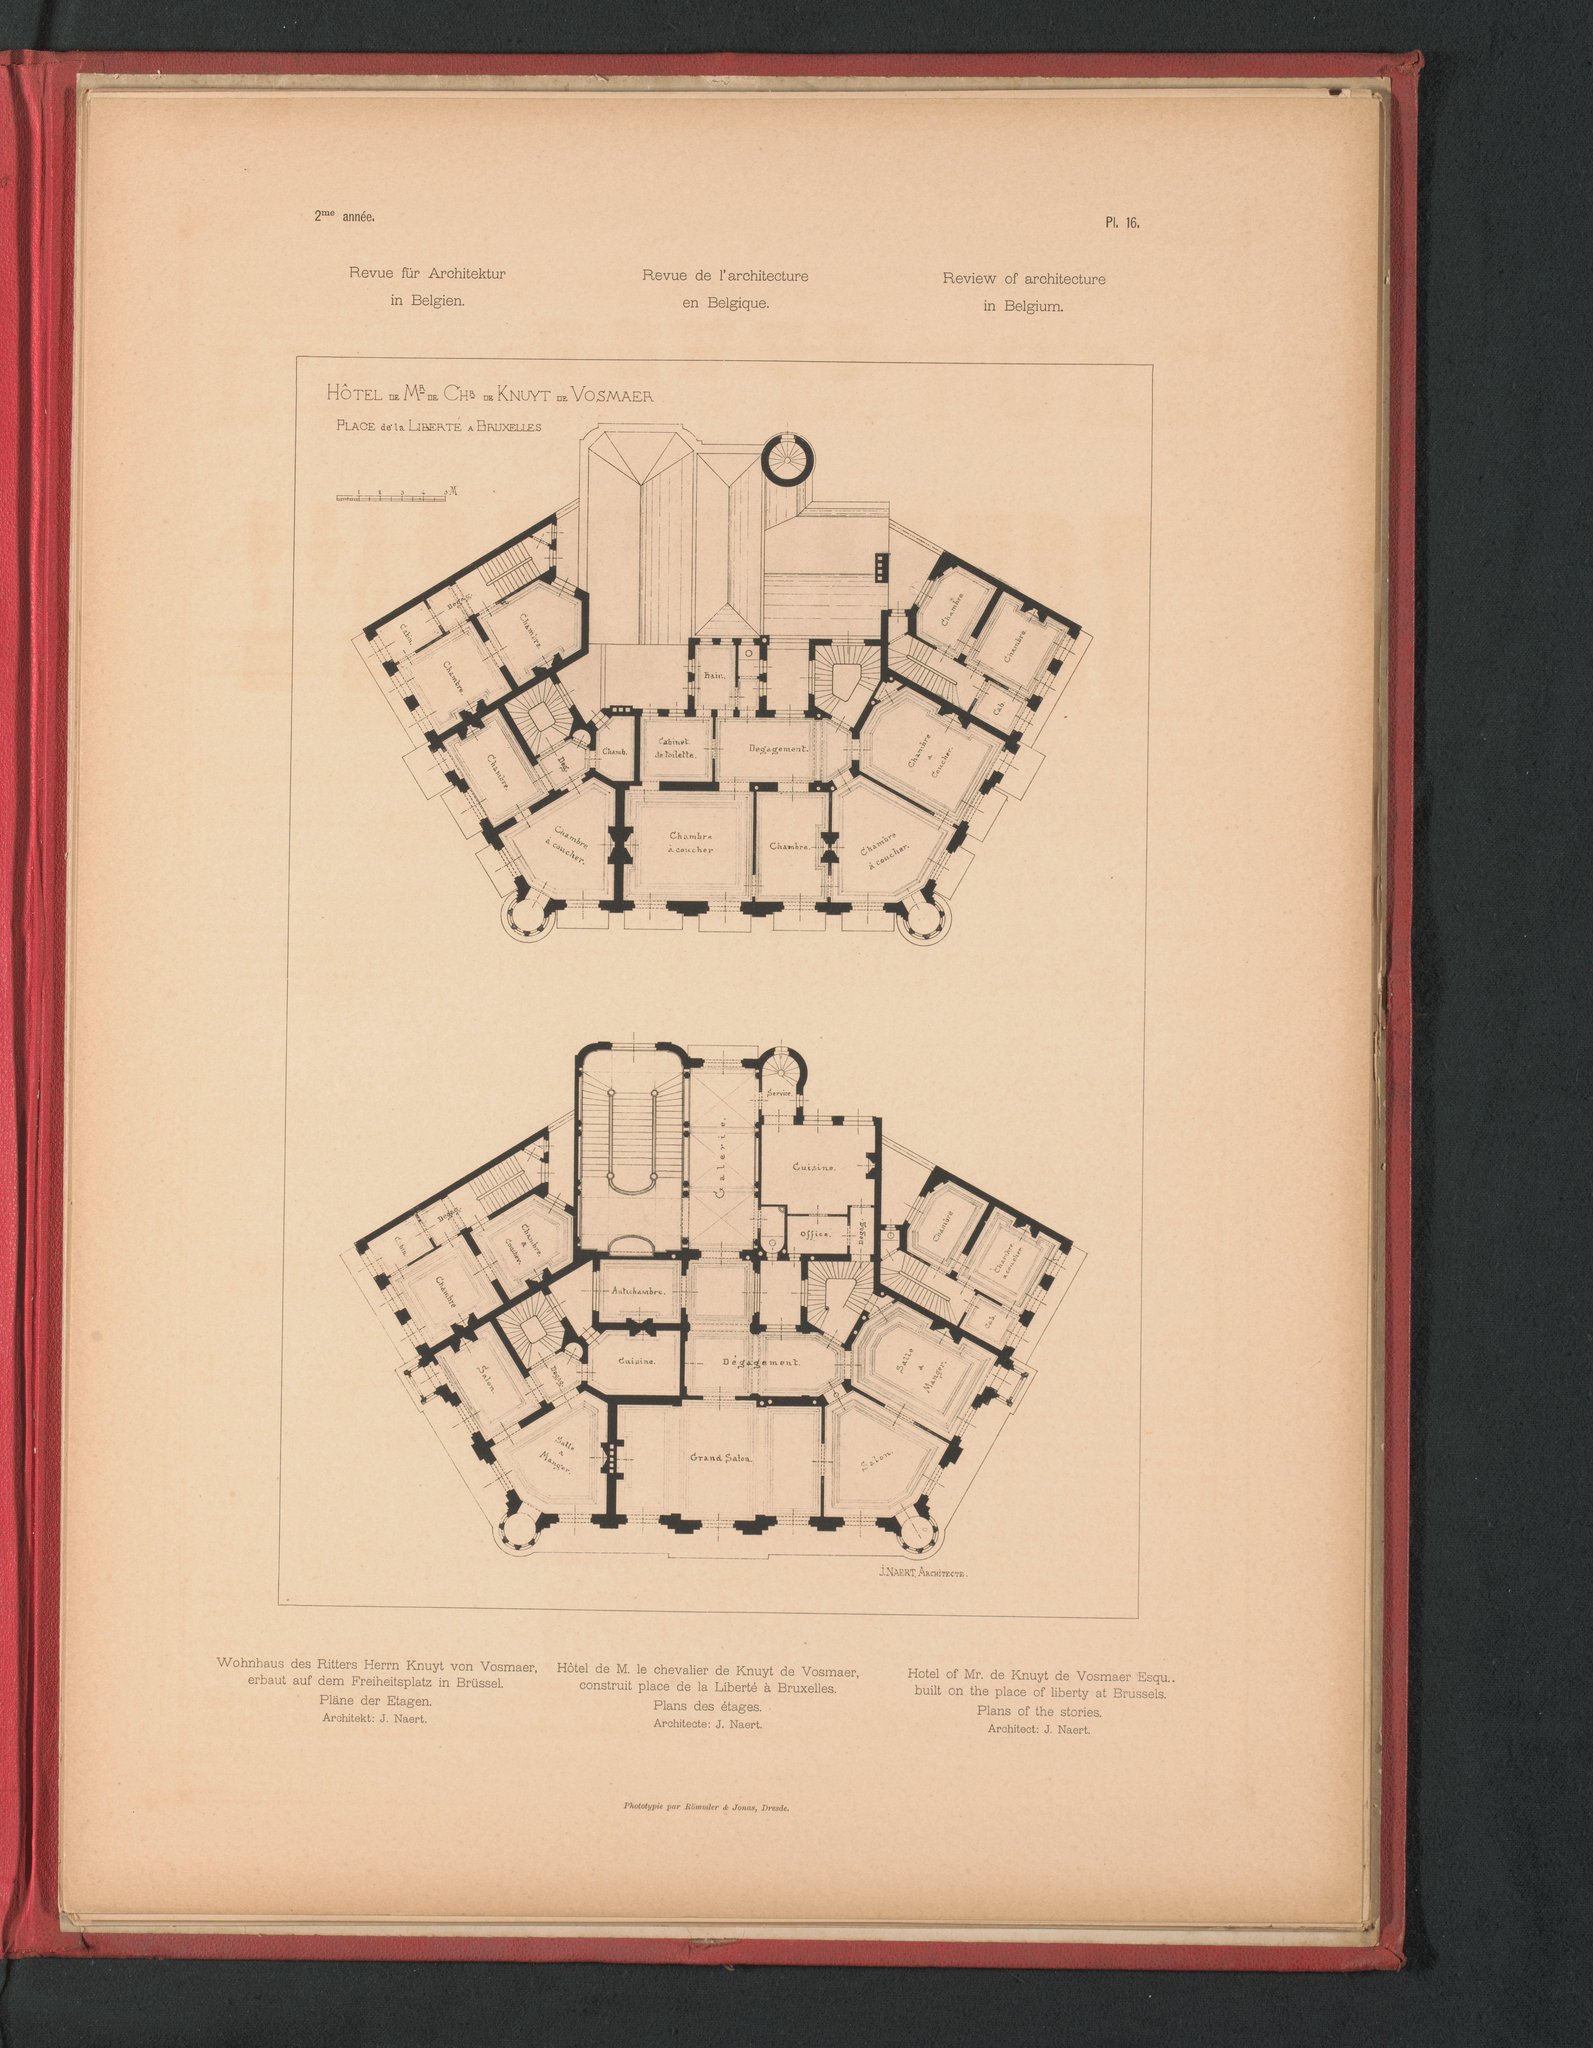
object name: photomechanical print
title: Wohnhaus des Ritters Herrn Knuyt von Vosmaer, erbaut auf dem Freiheitsplatz in Brüssel. Pläne der Etagen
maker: joseph naert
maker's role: architect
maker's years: 1838-1910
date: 1888-1893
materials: paper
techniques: photograph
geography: dresden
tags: plan ~ architecture, civic architecture; edifices; dwellings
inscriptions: number: ‘Pl. 16.’, inscription: ‘2me. année.’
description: Deze prent maakt deel uit van een omslag met 110 prenten op 90 bladen en 18 tekstbladen.